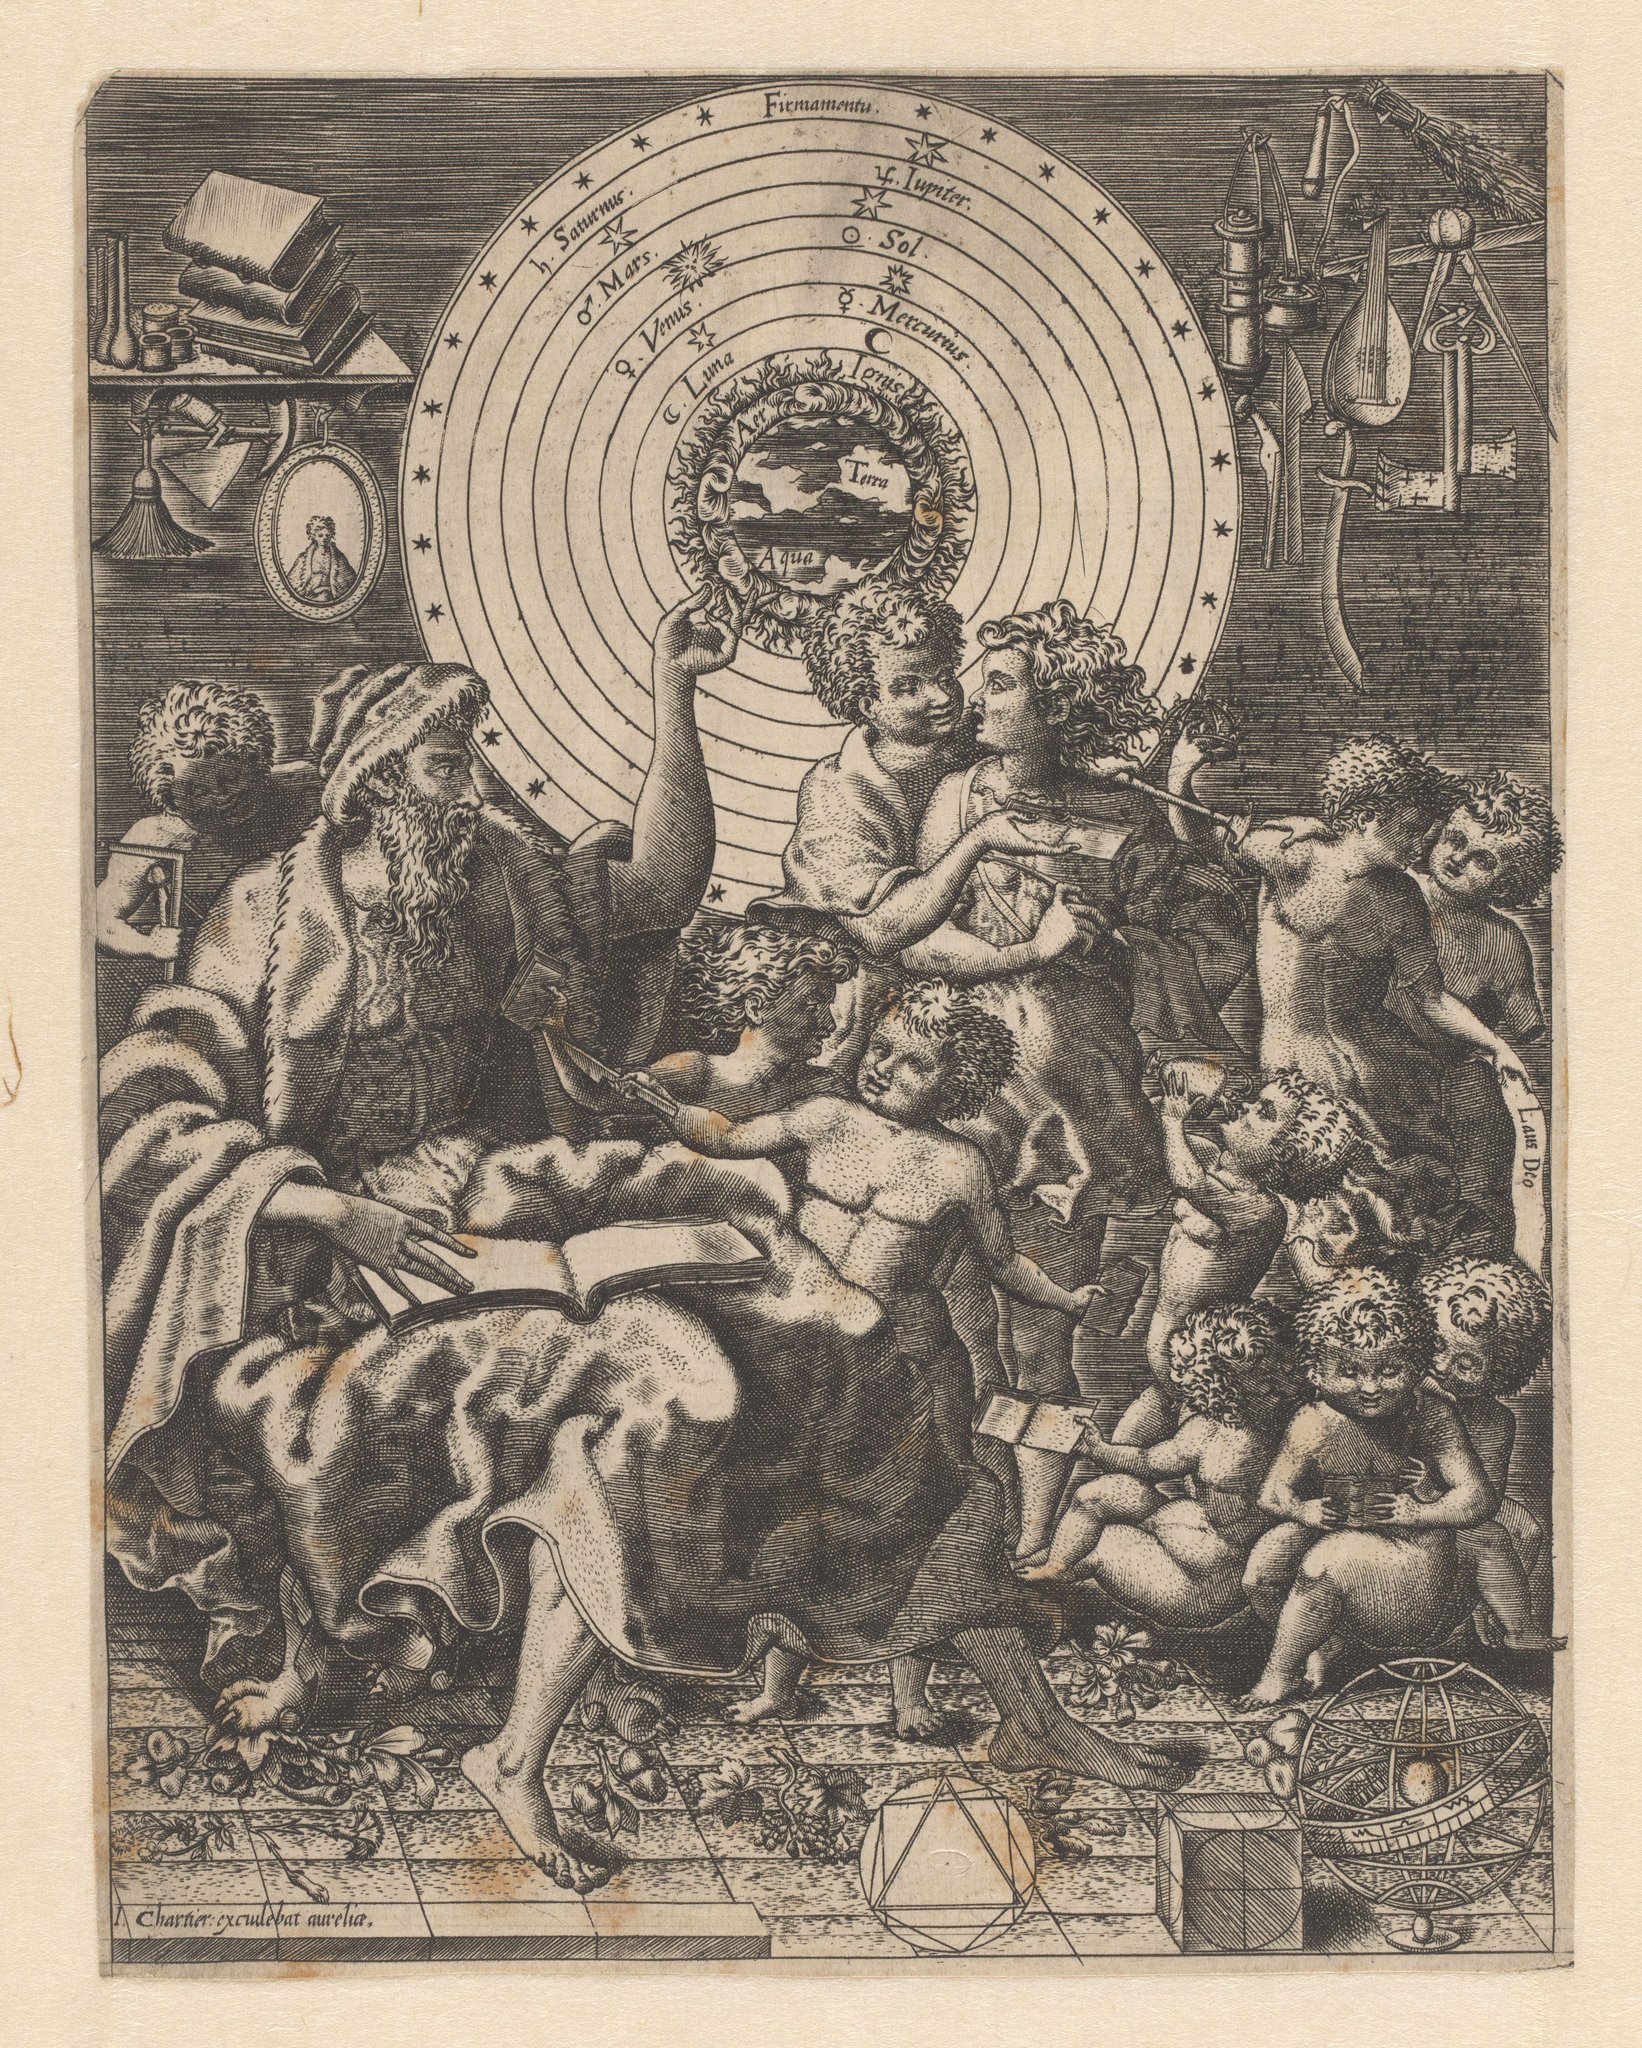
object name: print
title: Jean Chartier in zijn werkplaats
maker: jean chartier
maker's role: print maker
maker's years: 1500-1580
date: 1557-1580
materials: paper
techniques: engraving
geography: orléans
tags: print maker, jean chartier, engraver, etcher, portrait, self-portrait of artist, armillary sphere, skeleton celestial globe, planets; planetary system, solar system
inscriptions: collector's mark: Lugt 2200, collector's mark: Lugt 2760, collector's mark: Lugt 2228